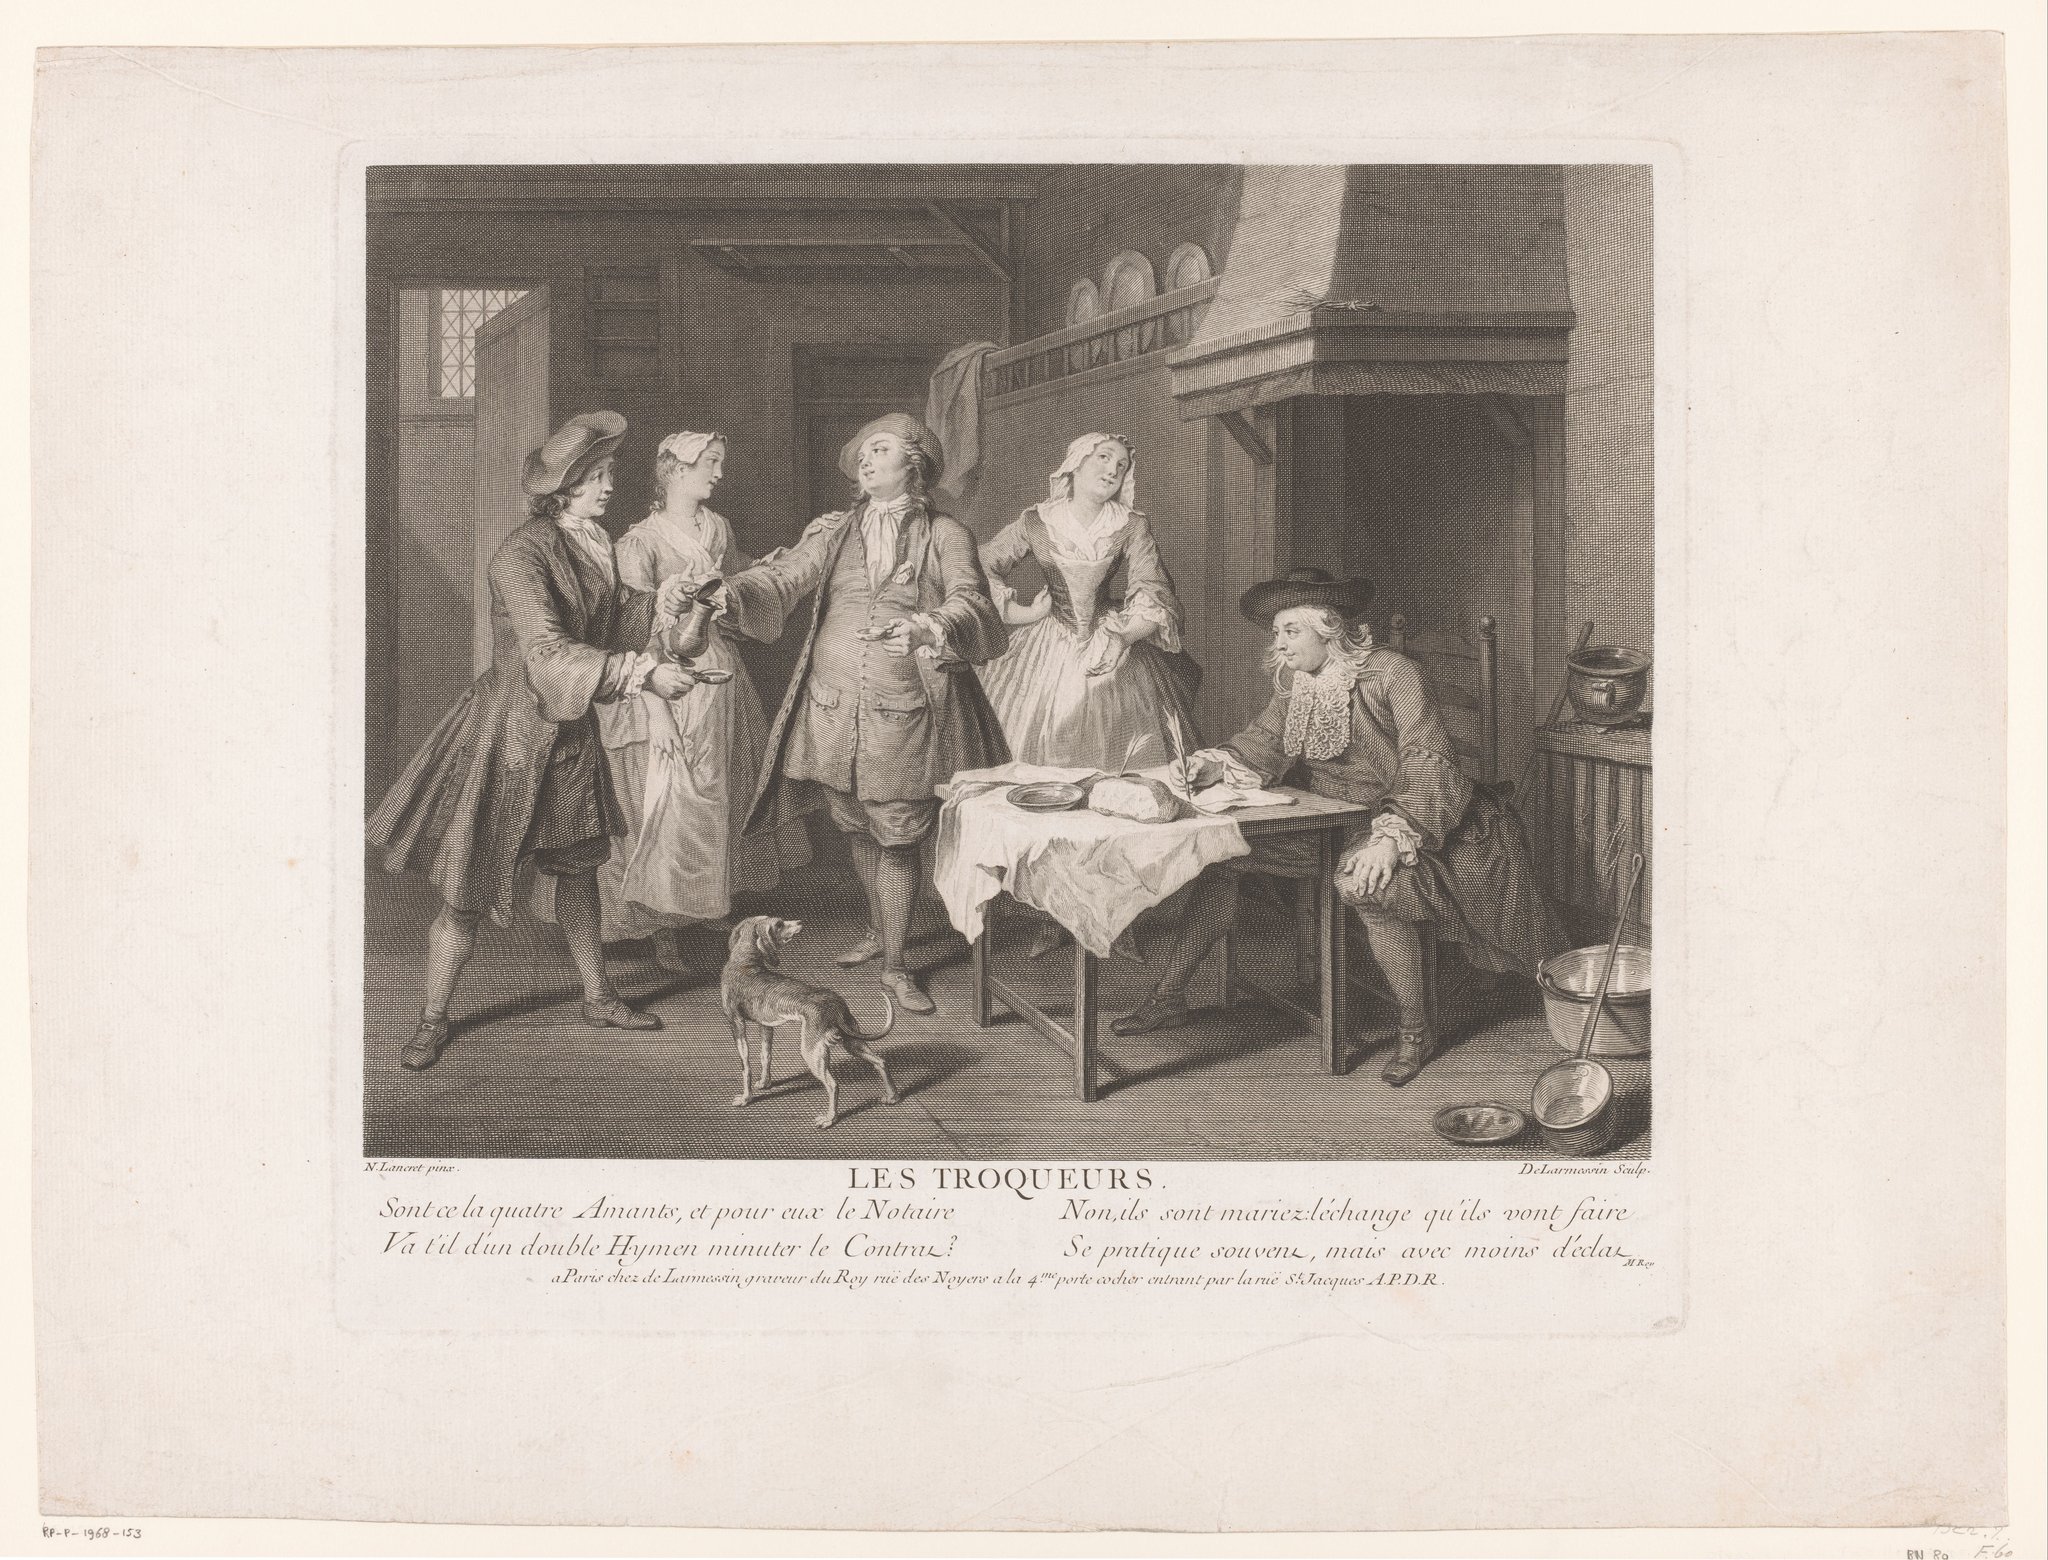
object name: print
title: Fabels van Jean de La Fontaine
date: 1738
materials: paper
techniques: engraving, etching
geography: paris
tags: kitchen-interior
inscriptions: collector's mark: Lugt 2228, collector's mark: Lugt 2760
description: Maakt deel uit van een 38-delige serie met prenten bij de verhalen van La Fontaine, gegraveerd tussen 1736-1743.